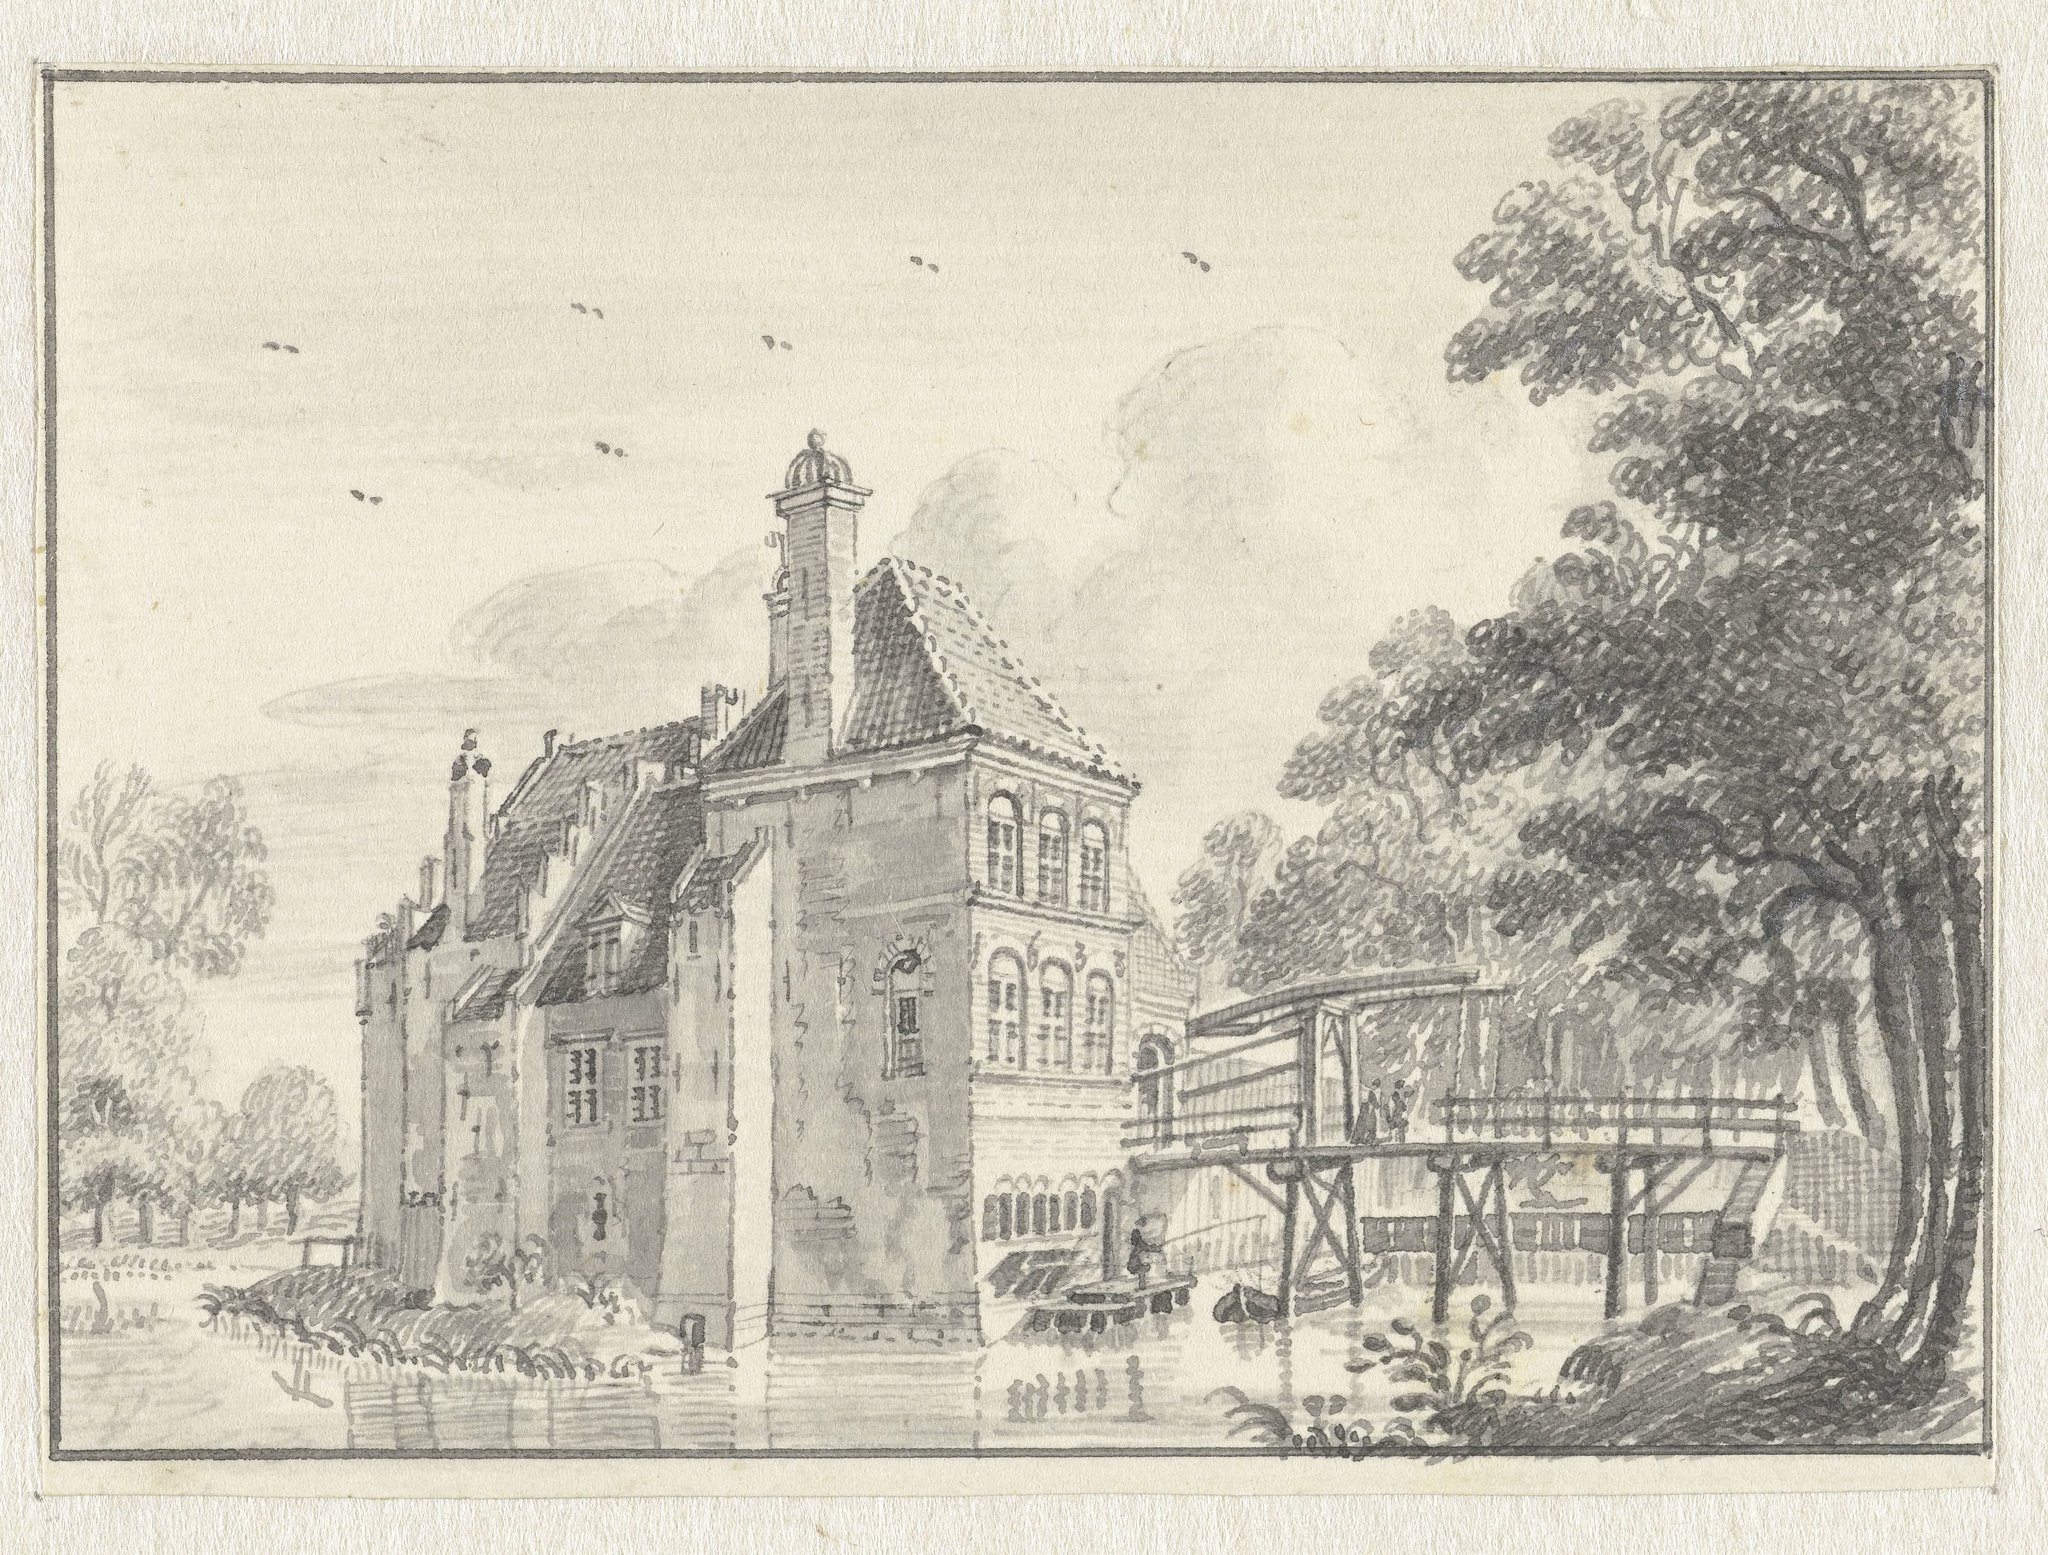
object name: drawing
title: Het Huis te Harmelen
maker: jan de beijer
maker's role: draughtsman, print maker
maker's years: 1703-1780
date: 1744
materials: ink, paper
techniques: brush, pen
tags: castle